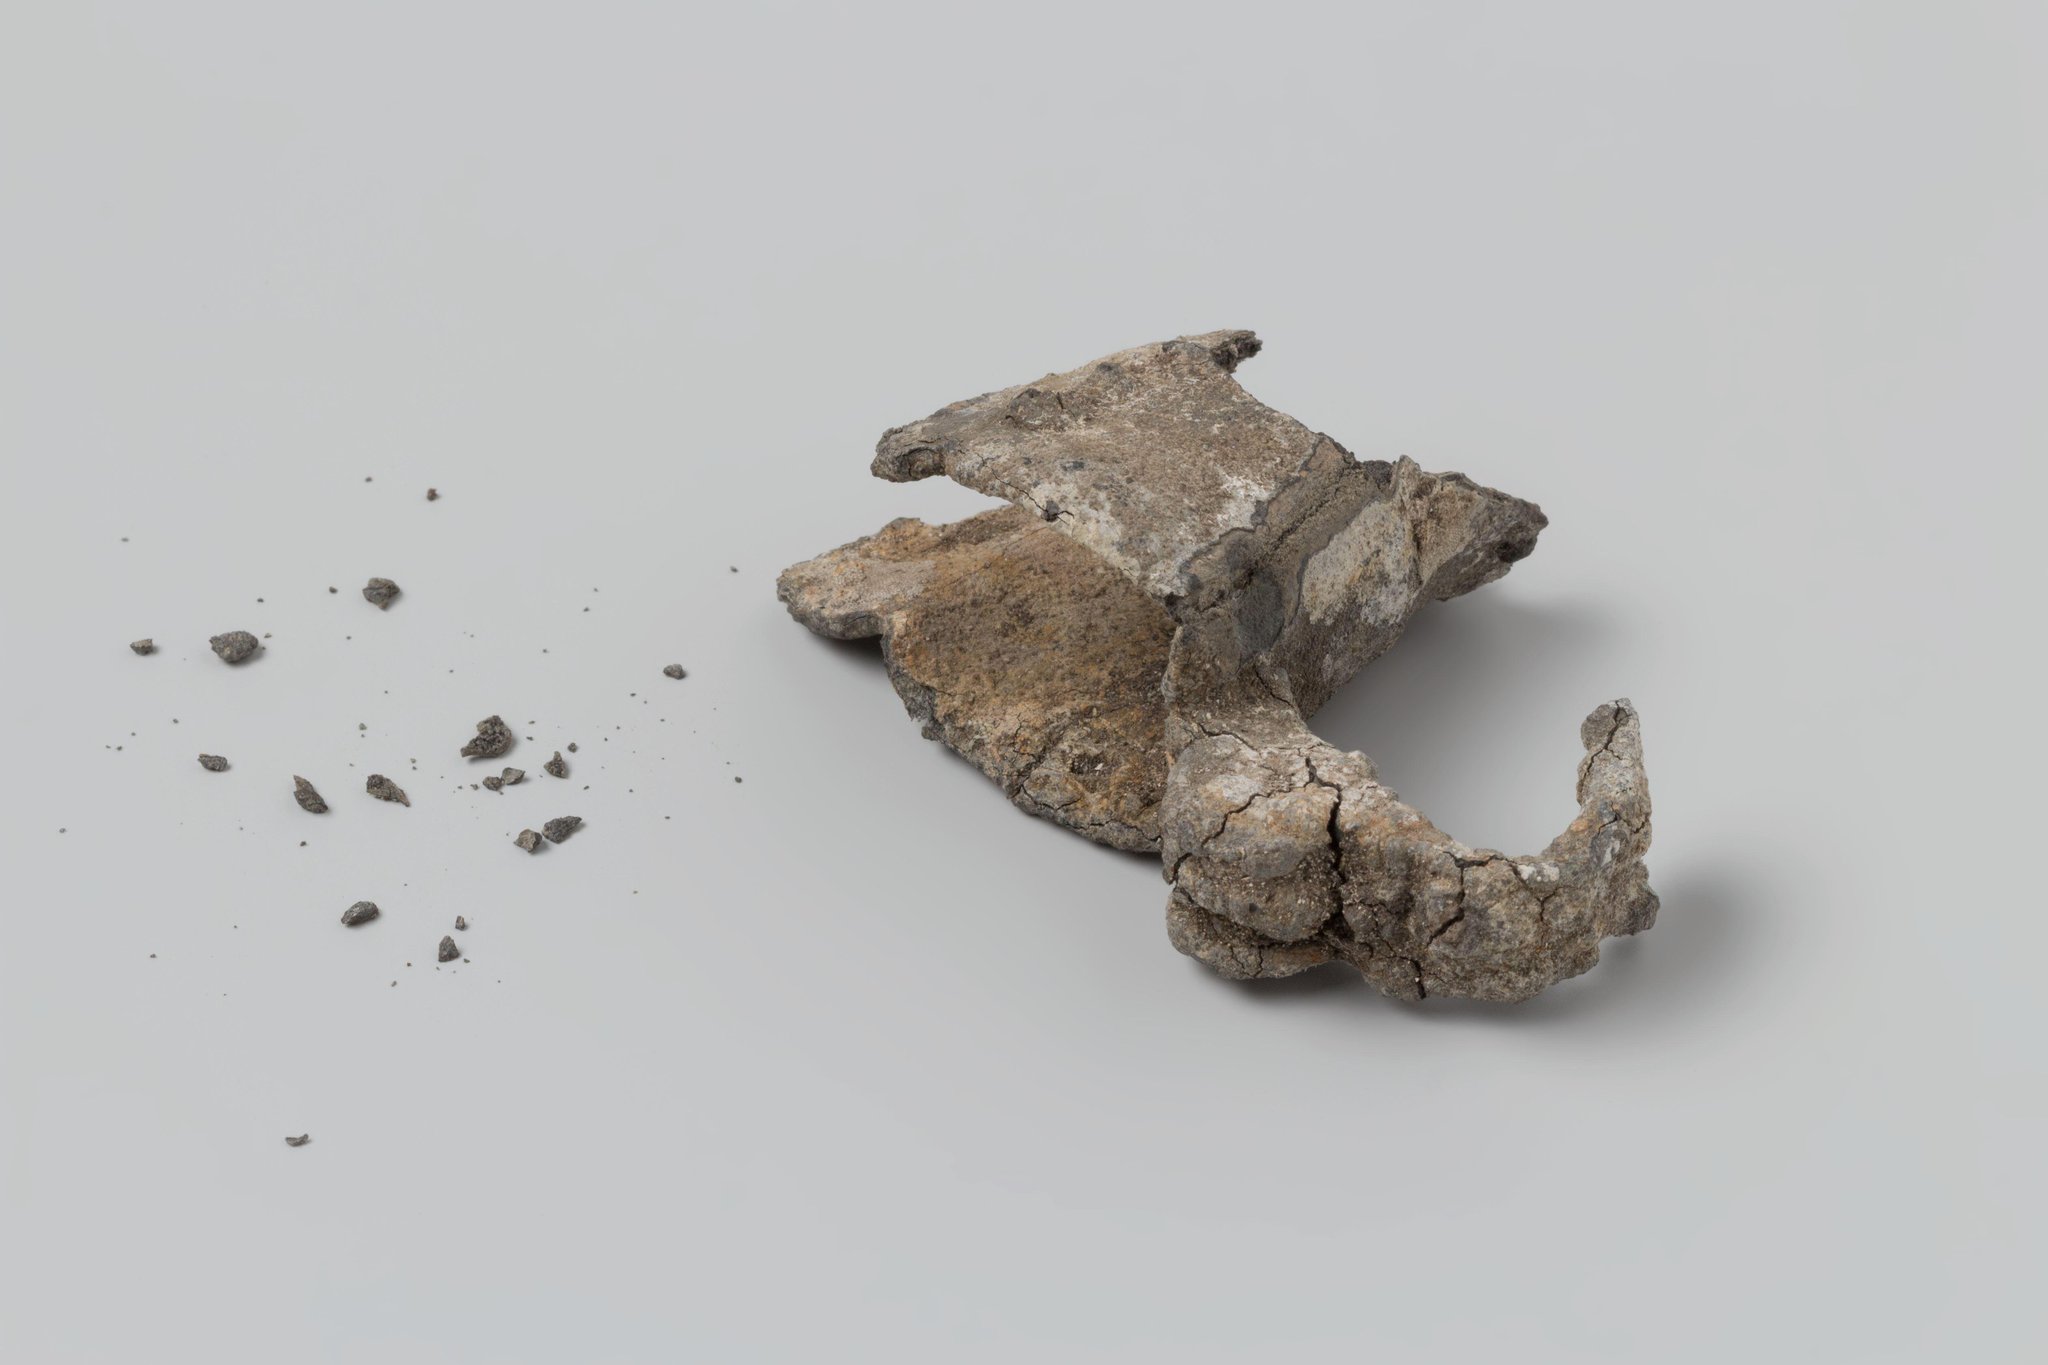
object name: flapkan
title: Kraag en oor van een flapkan uit V.O.C.-schip de 'Witte Leeuw'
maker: Anonymous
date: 1613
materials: tin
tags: verenigde oostindische compagnie, sint-helena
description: Kraag en oor van een flapkan uit V.O.C.-schip de 'Witte Leeuw'.